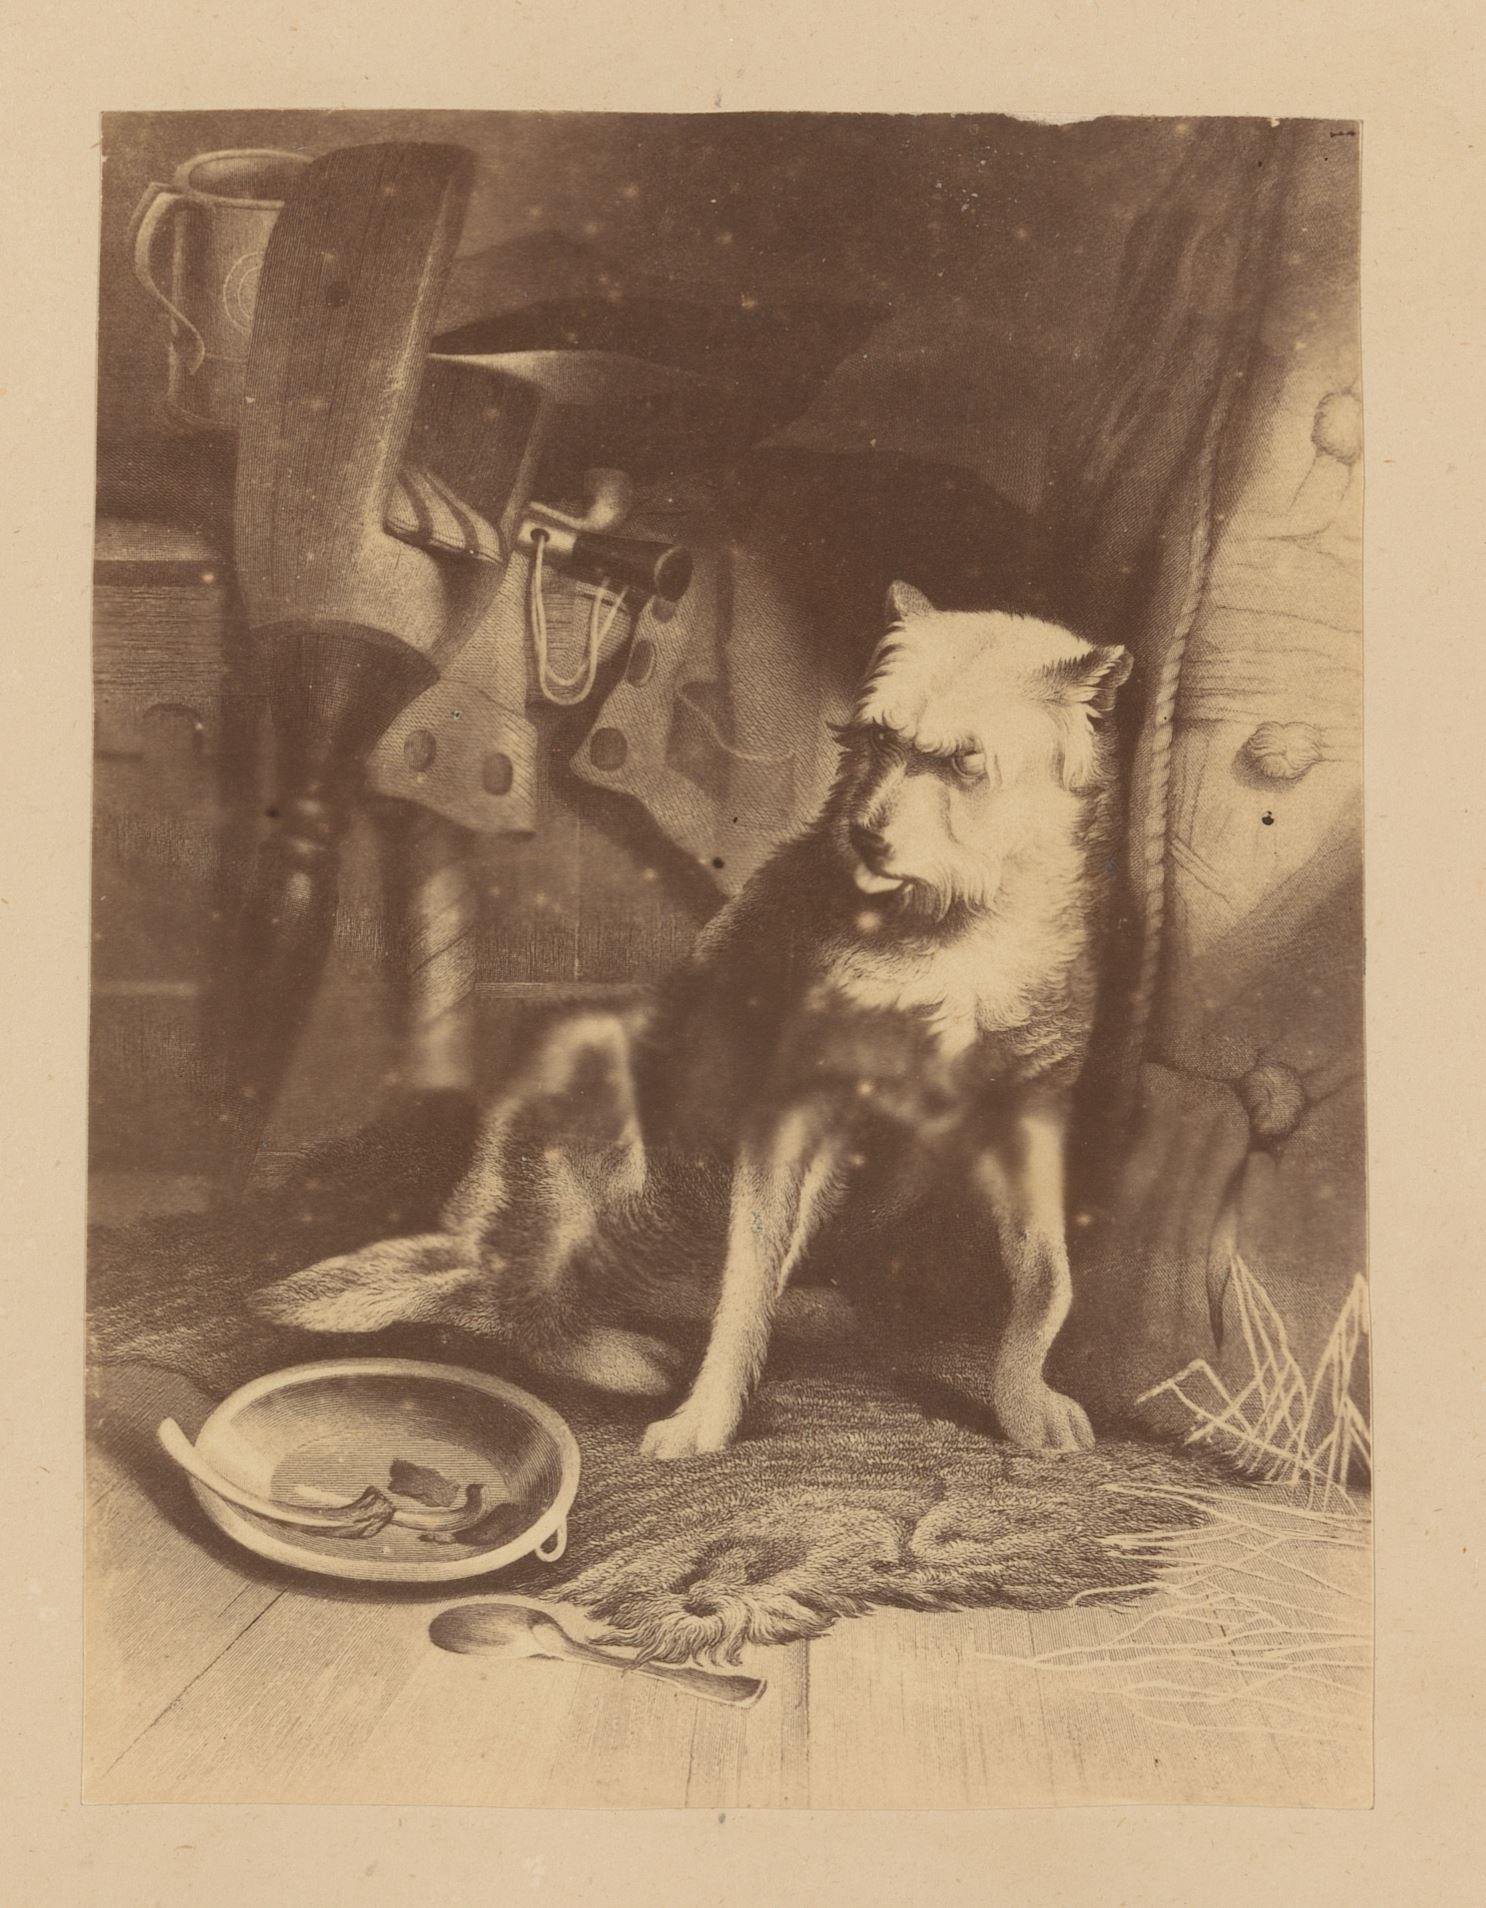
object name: photograph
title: Fotoreproductie van een prent met hond op een kleed bij een bord met afgekloven botten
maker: Anonymous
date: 1875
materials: photographic support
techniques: albumen print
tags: dog